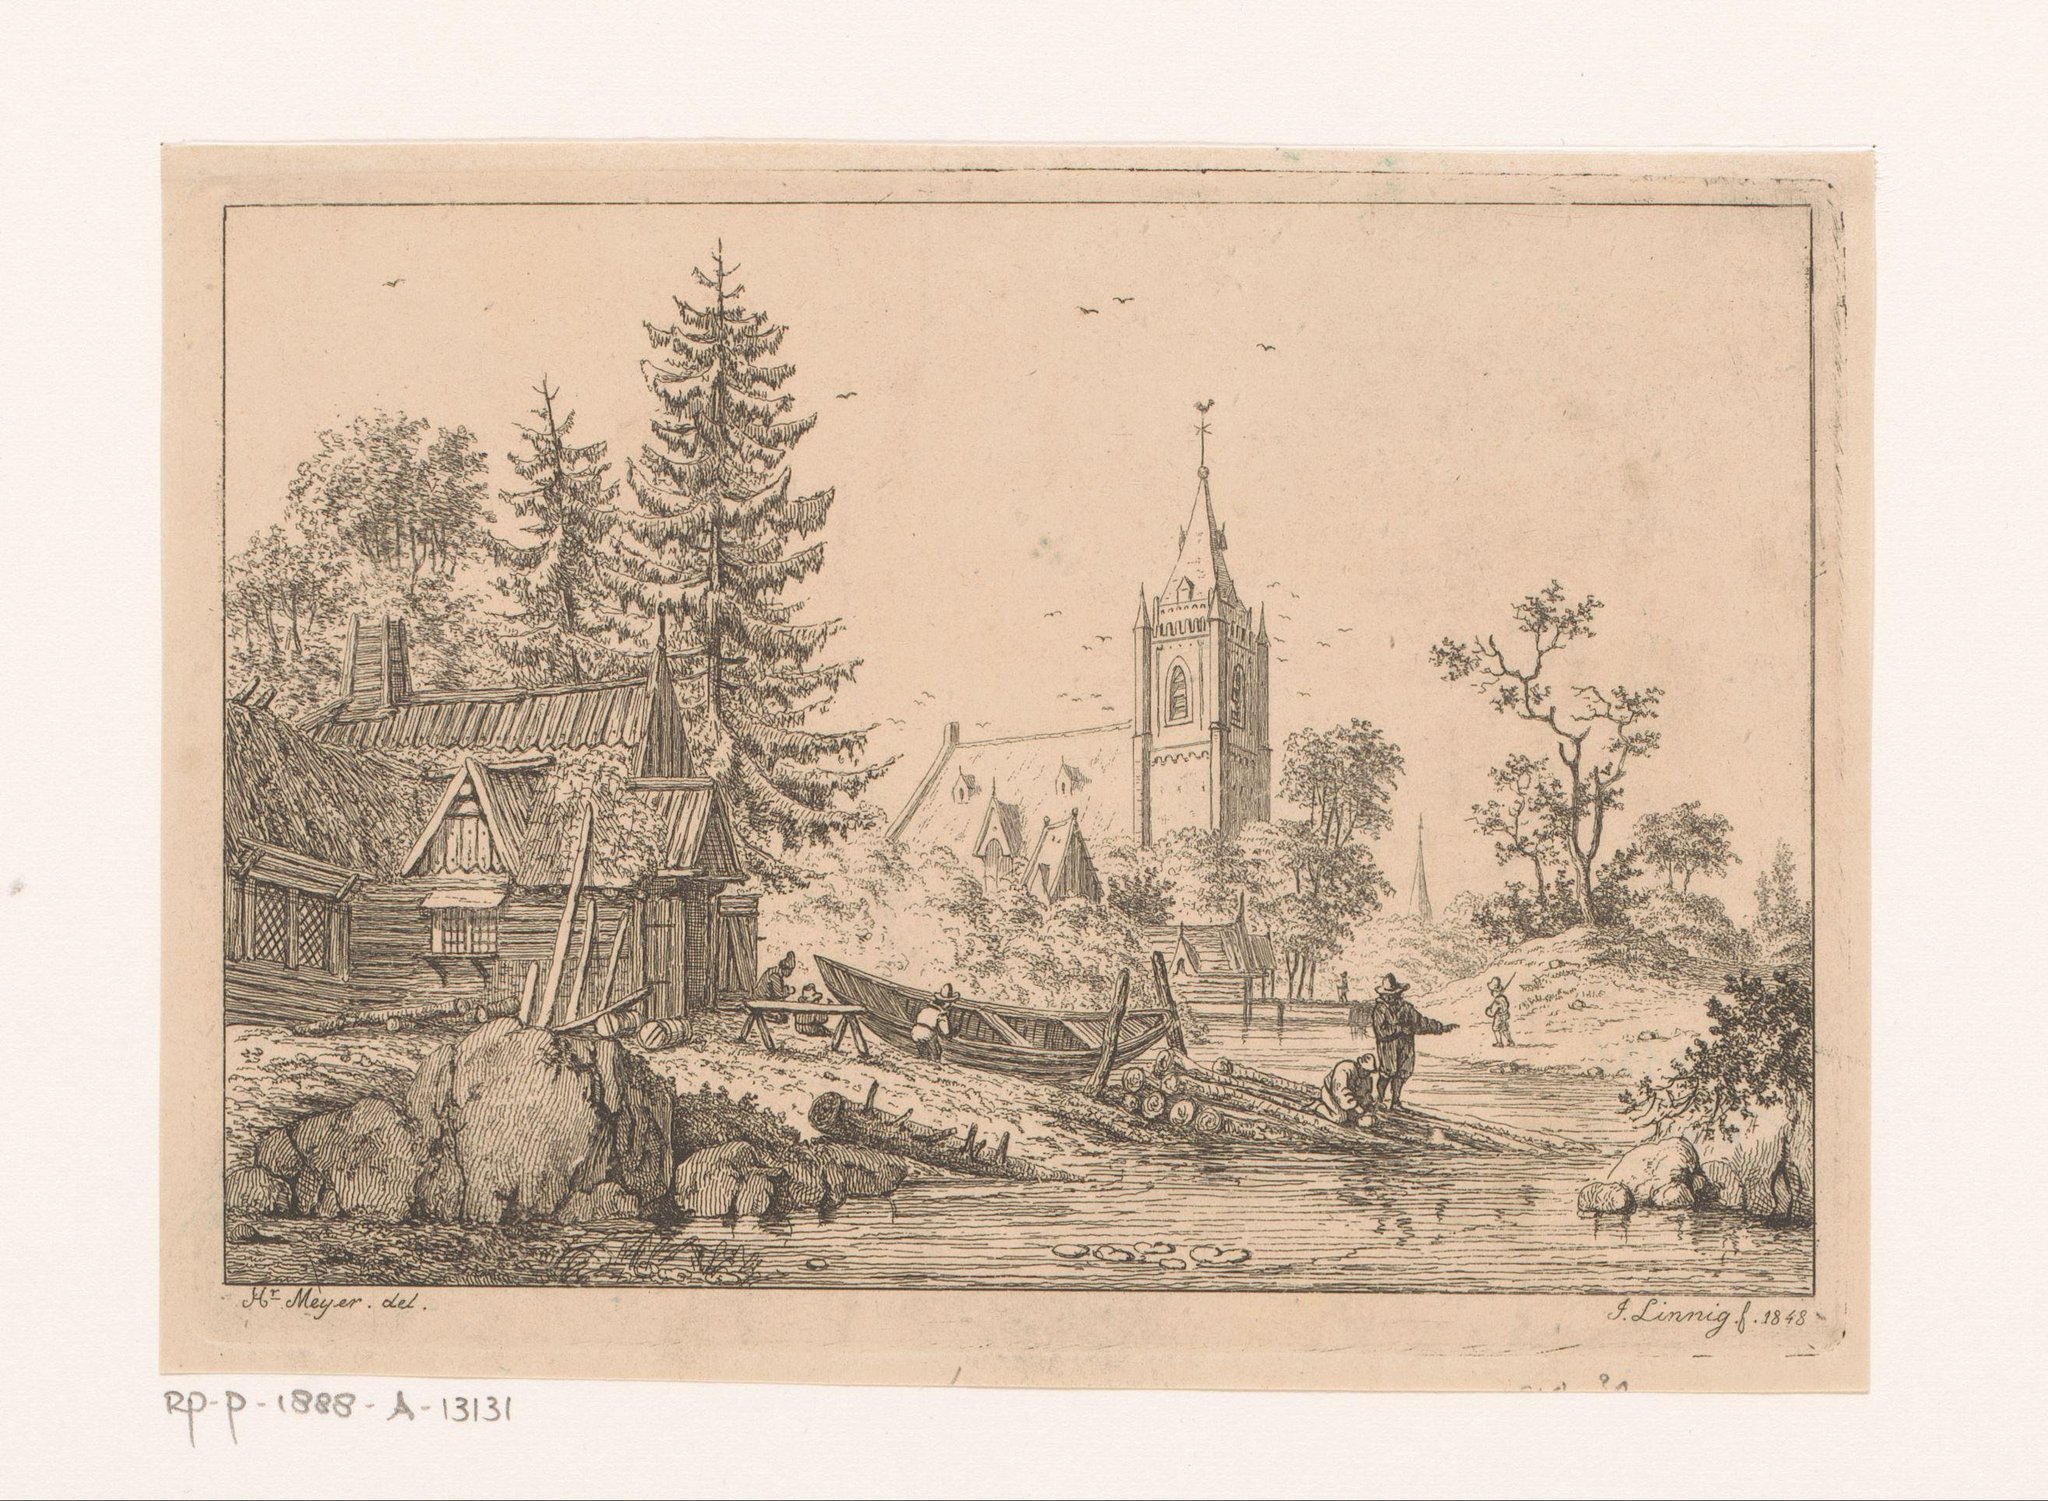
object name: print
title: Scheepstimmerwerf met een kerk op de achtergrond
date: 1848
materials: paper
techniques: etching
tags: church (exterior), shipyard, shipdock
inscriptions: collector's mark: Lugt 2228